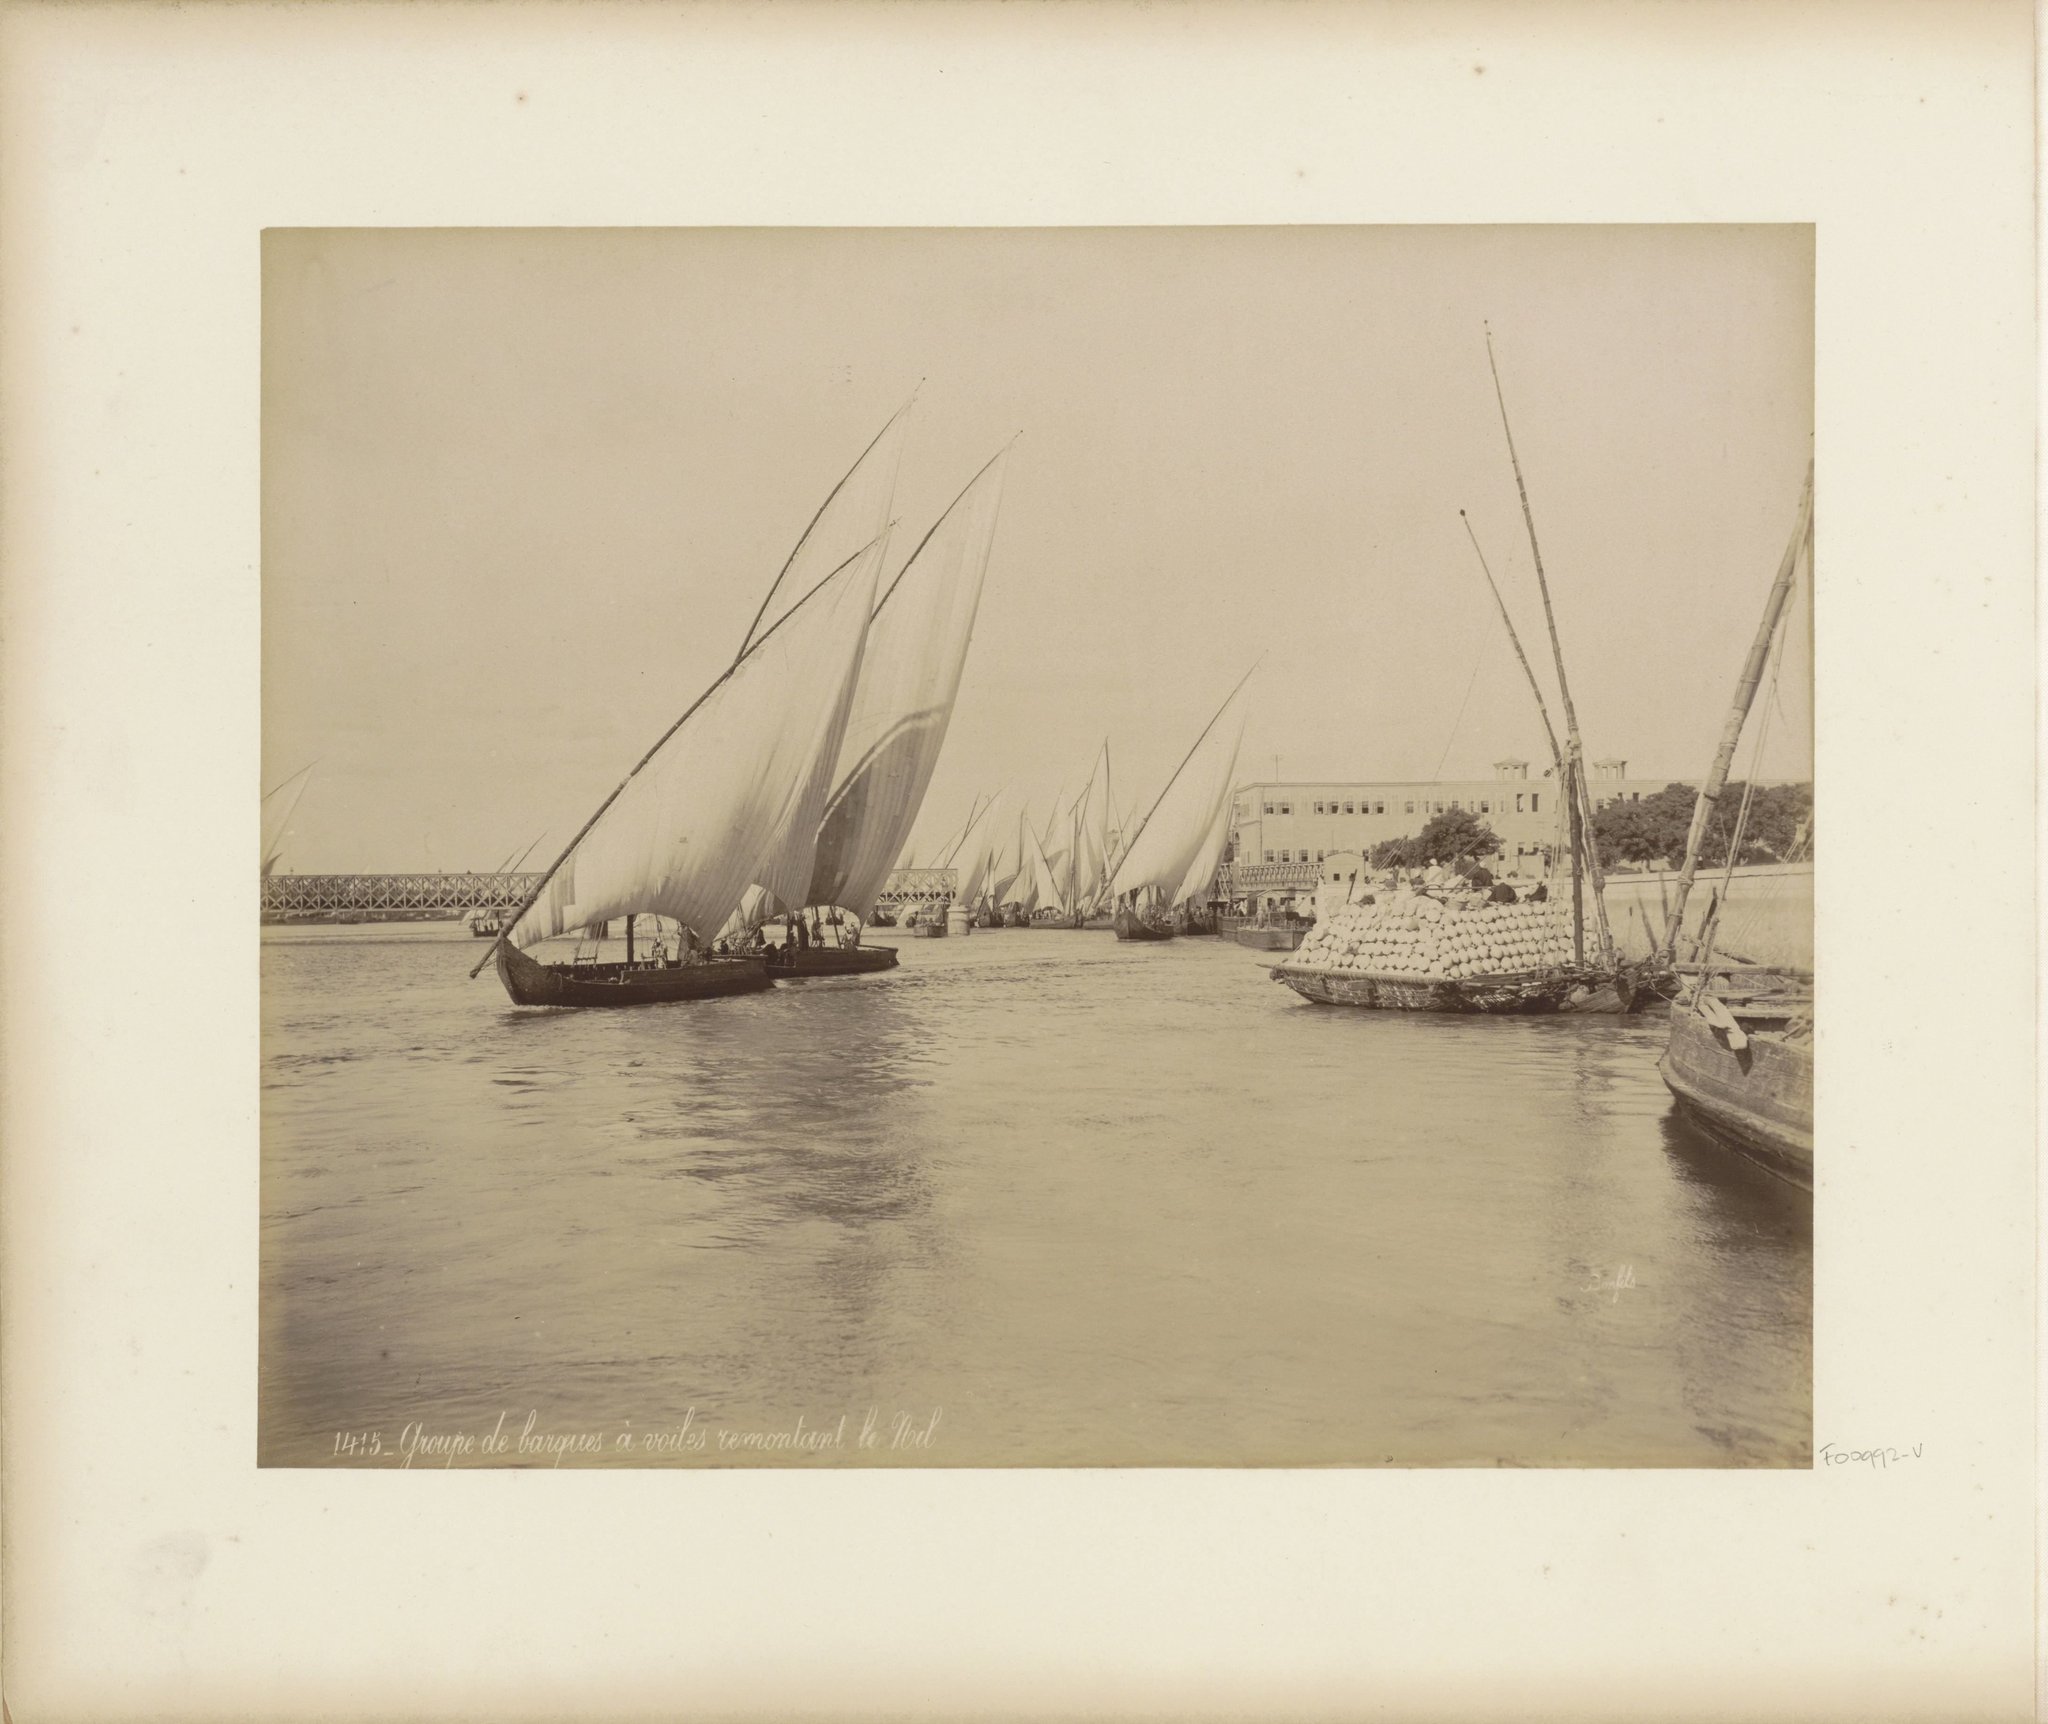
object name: photograph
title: Zeilboten met vracht op de Nijl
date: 1870-1898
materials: cardboard, paper, photographic support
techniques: albumen print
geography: egypt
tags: sailing-ship, sailing-boat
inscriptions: negative number: ‘1415’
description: Onderdeel van Reisalbum met 80 foto's van Egypte.